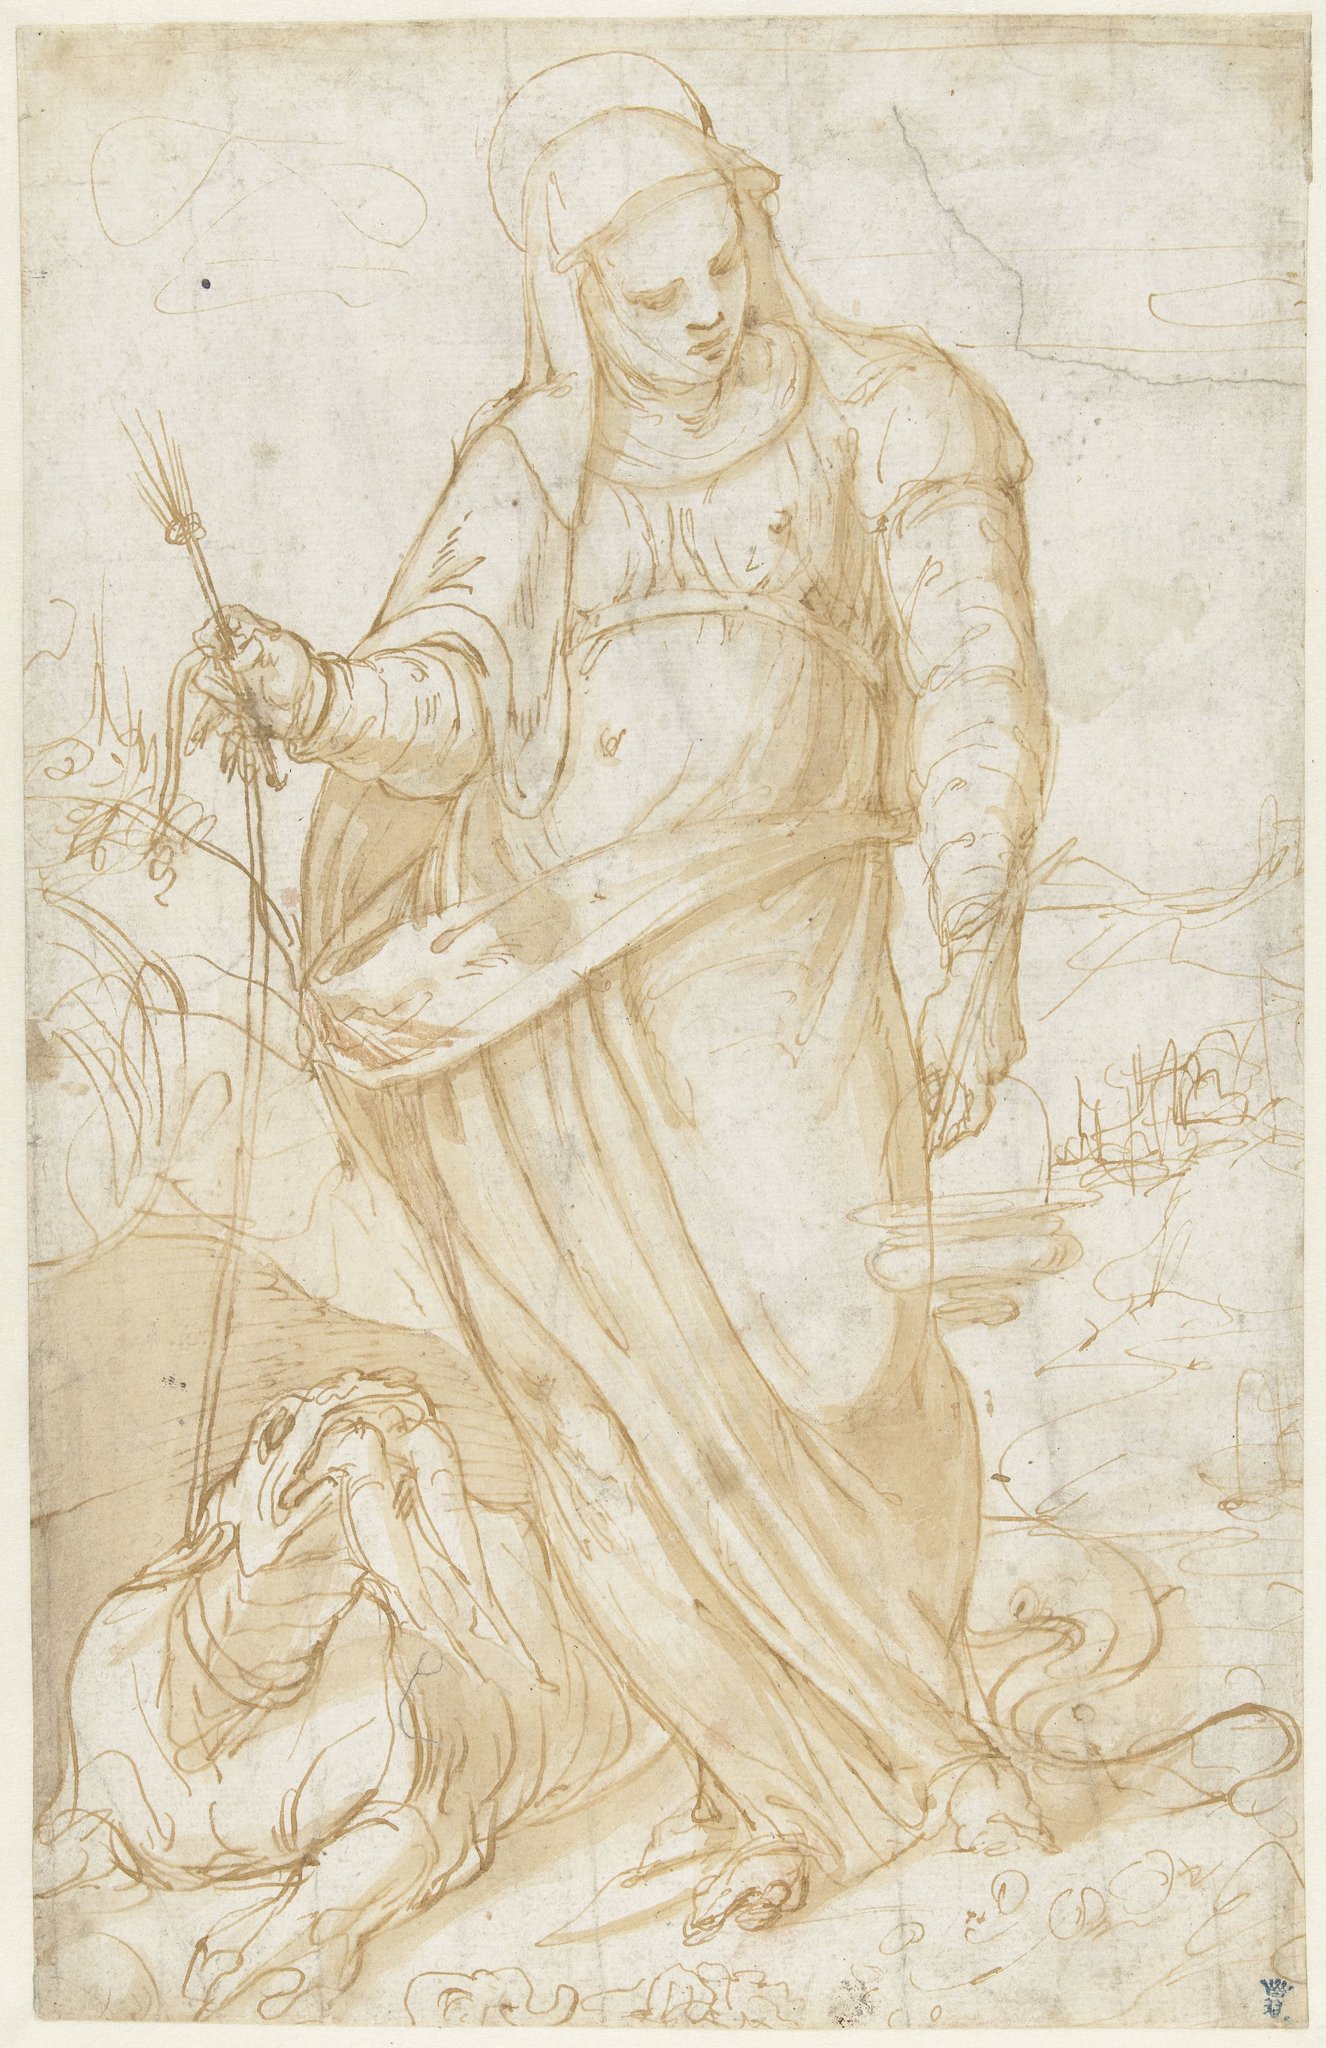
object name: drawing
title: Heilige Margaretha met de draak in een landschap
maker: giovanni cambiaso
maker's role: draughtsman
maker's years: 1495-1579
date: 1505-1579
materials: ink, paper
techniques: brush, pen